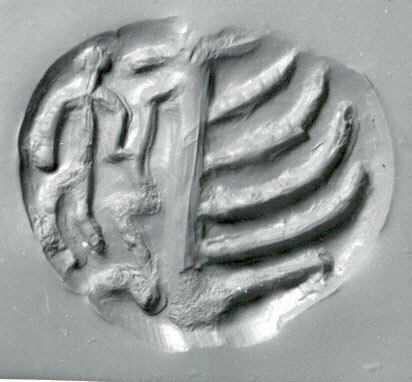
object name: stamp seal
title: Ovoid seal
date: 3100-2900 BCE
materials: mineral, stone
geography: northern syria or southeastern anatolia